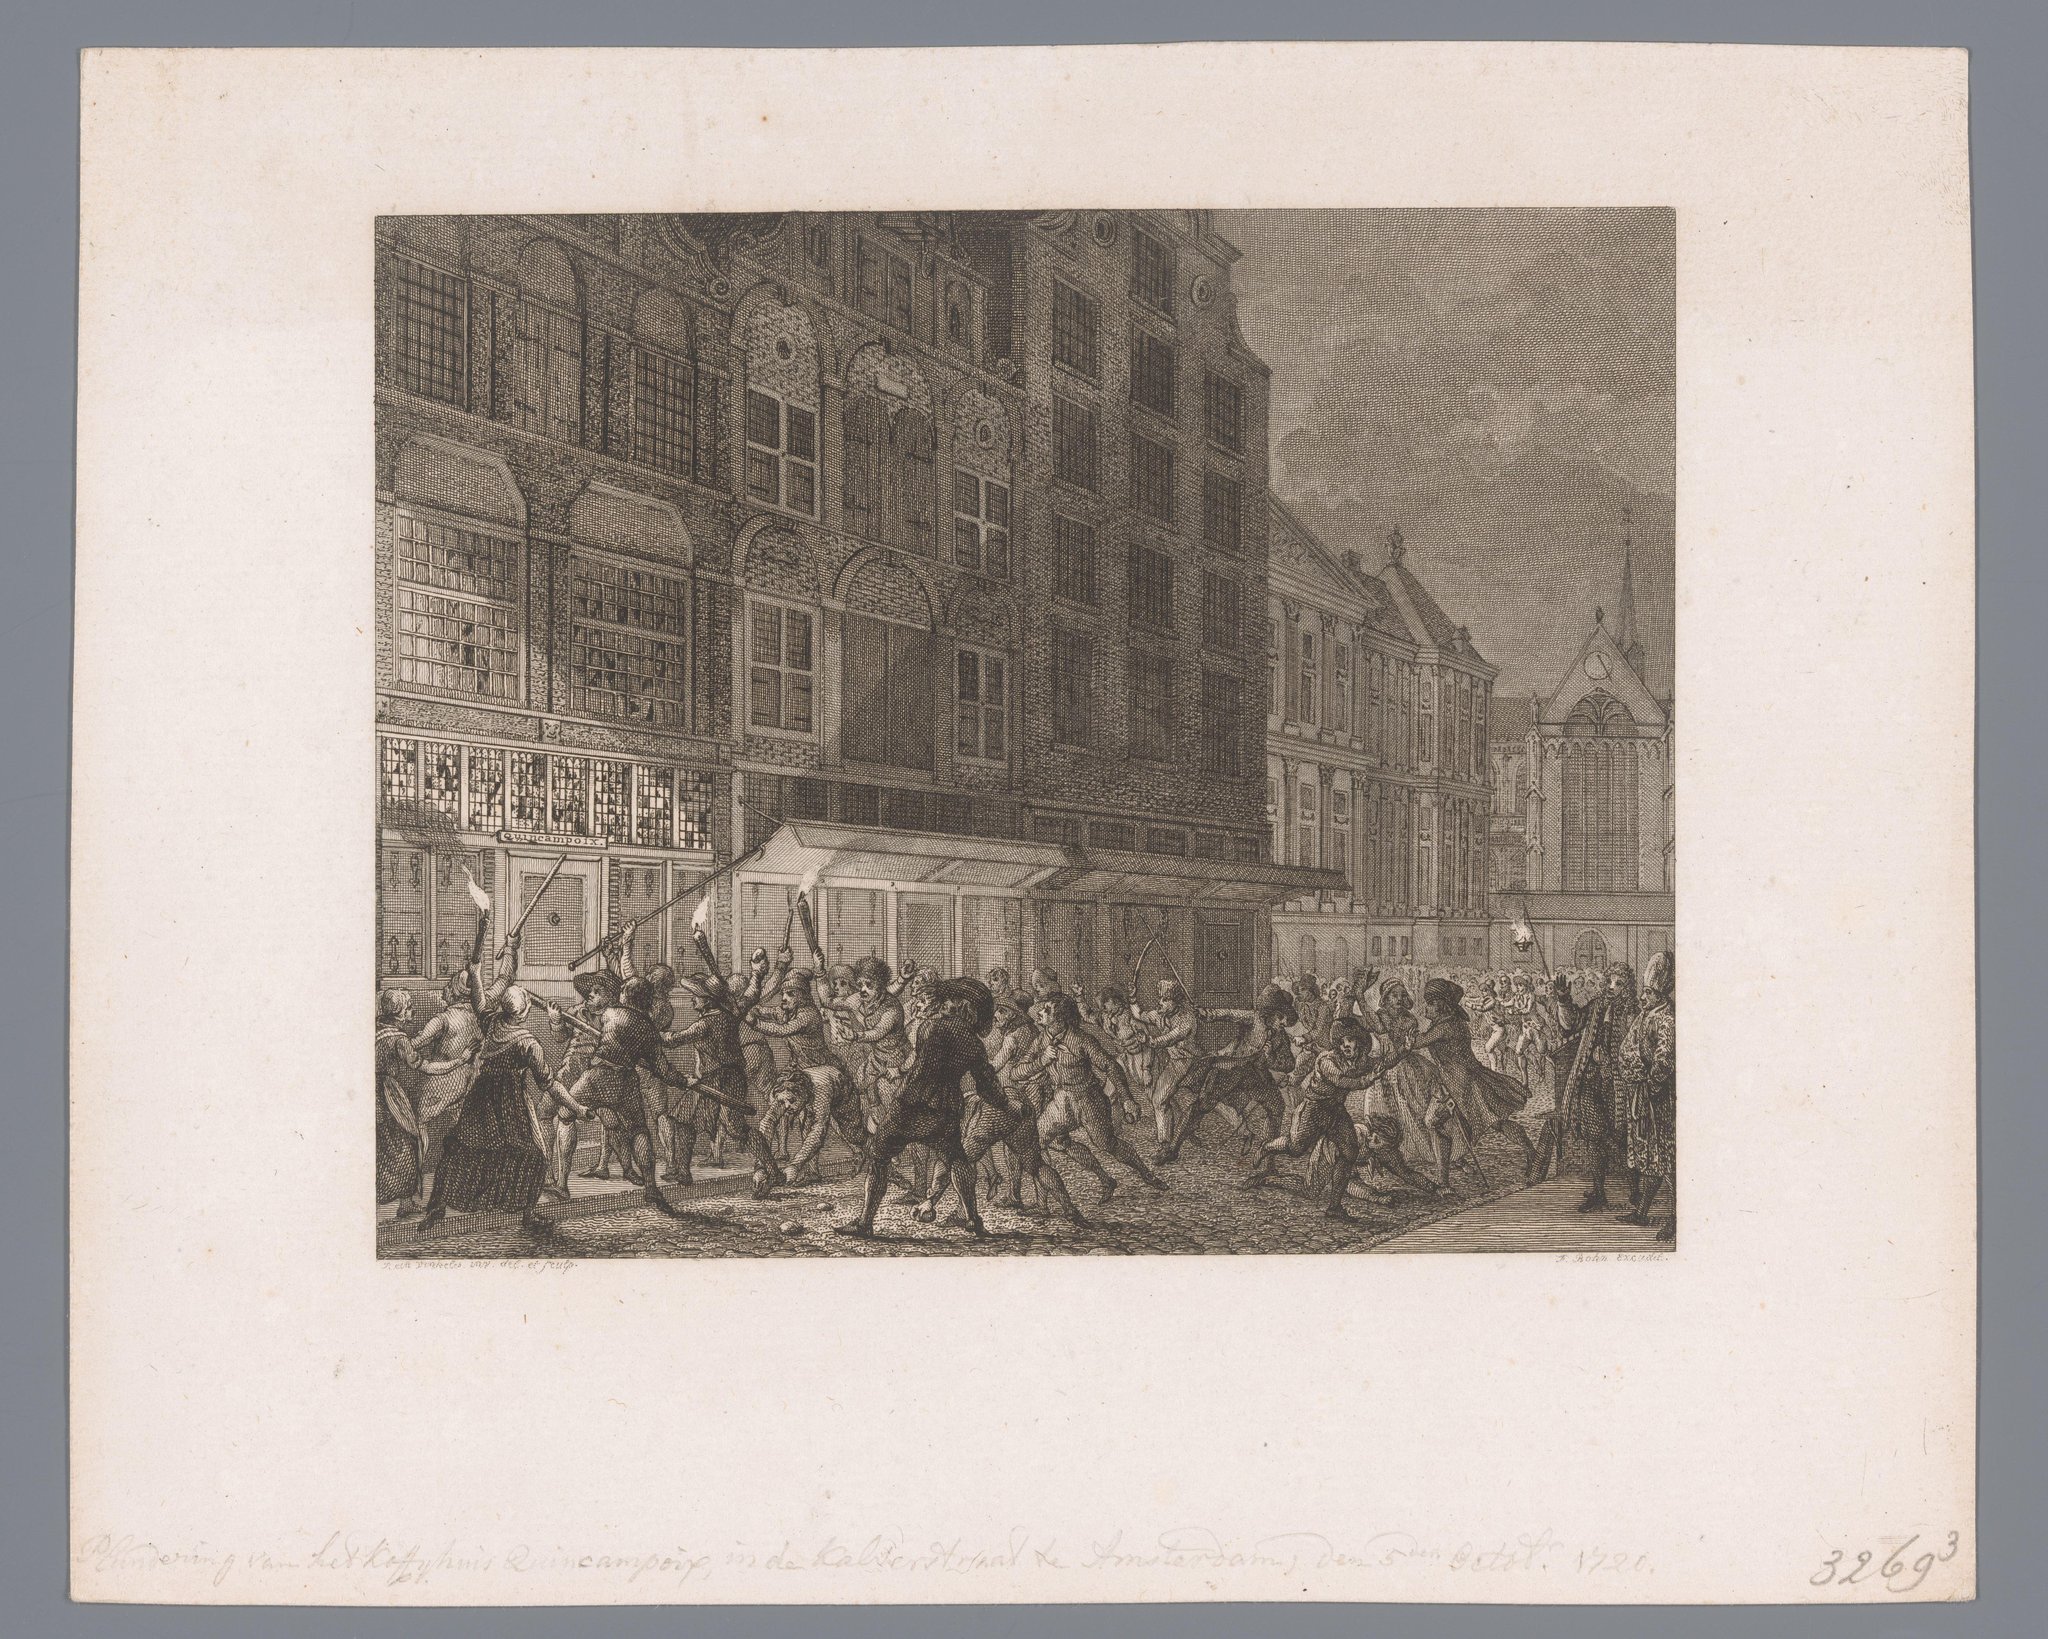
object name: print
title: Plundering van het koffiehuis Quincampoix in Amsterdam, 1720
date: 1751-1812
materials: paper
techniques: engraving, etching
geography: amsterdam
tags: negative results and undesired aspects of trading, plundering ~ riot, square, place, circus, etc. (+ city(-scape) with figures, staffage)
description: In het koffiehuis Quincampoix kwamen actiehandelaren bijeen. Op 5 oktober 1720 werd dit aangevallen door een woedende menigte in reactie op de zogenoemde windhandel.